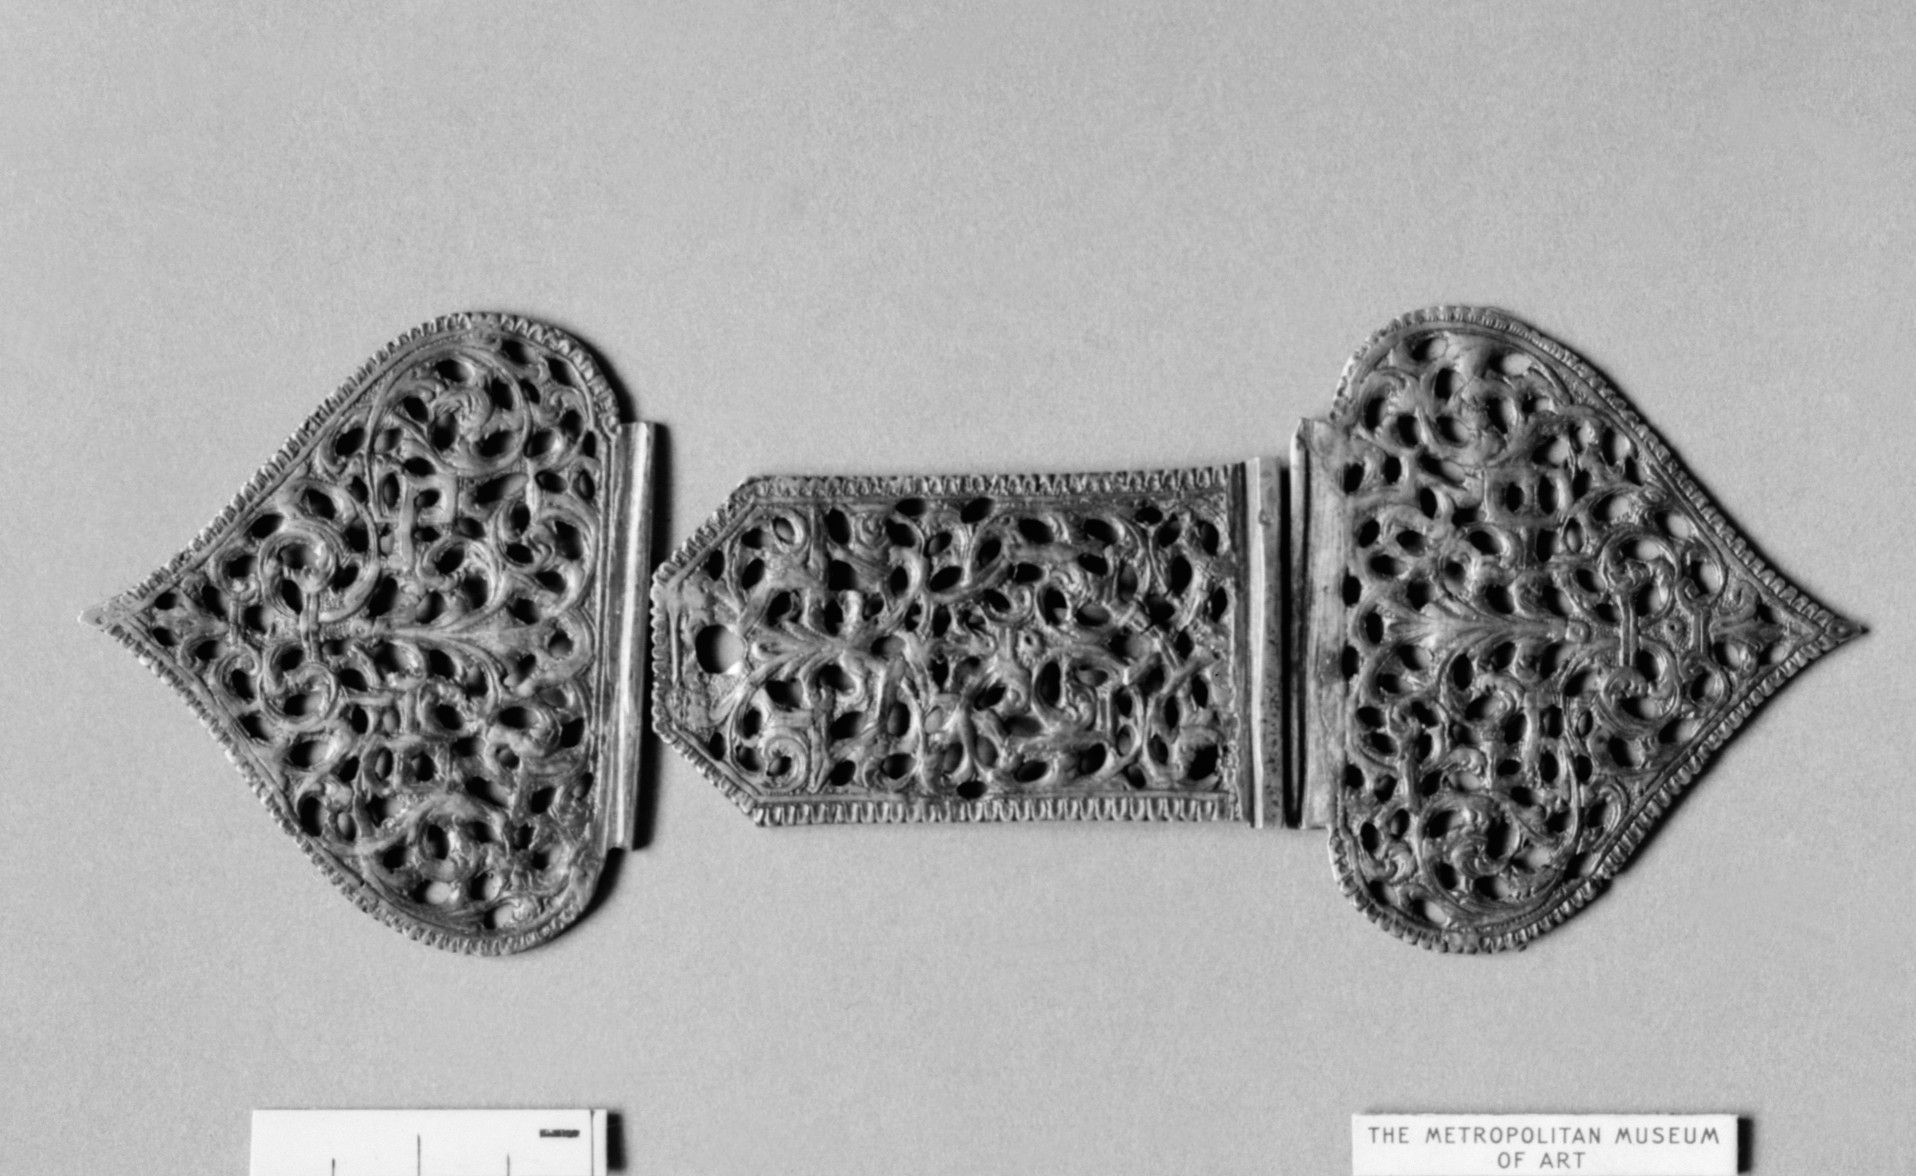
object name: book clasp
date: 1701-1800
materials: silver